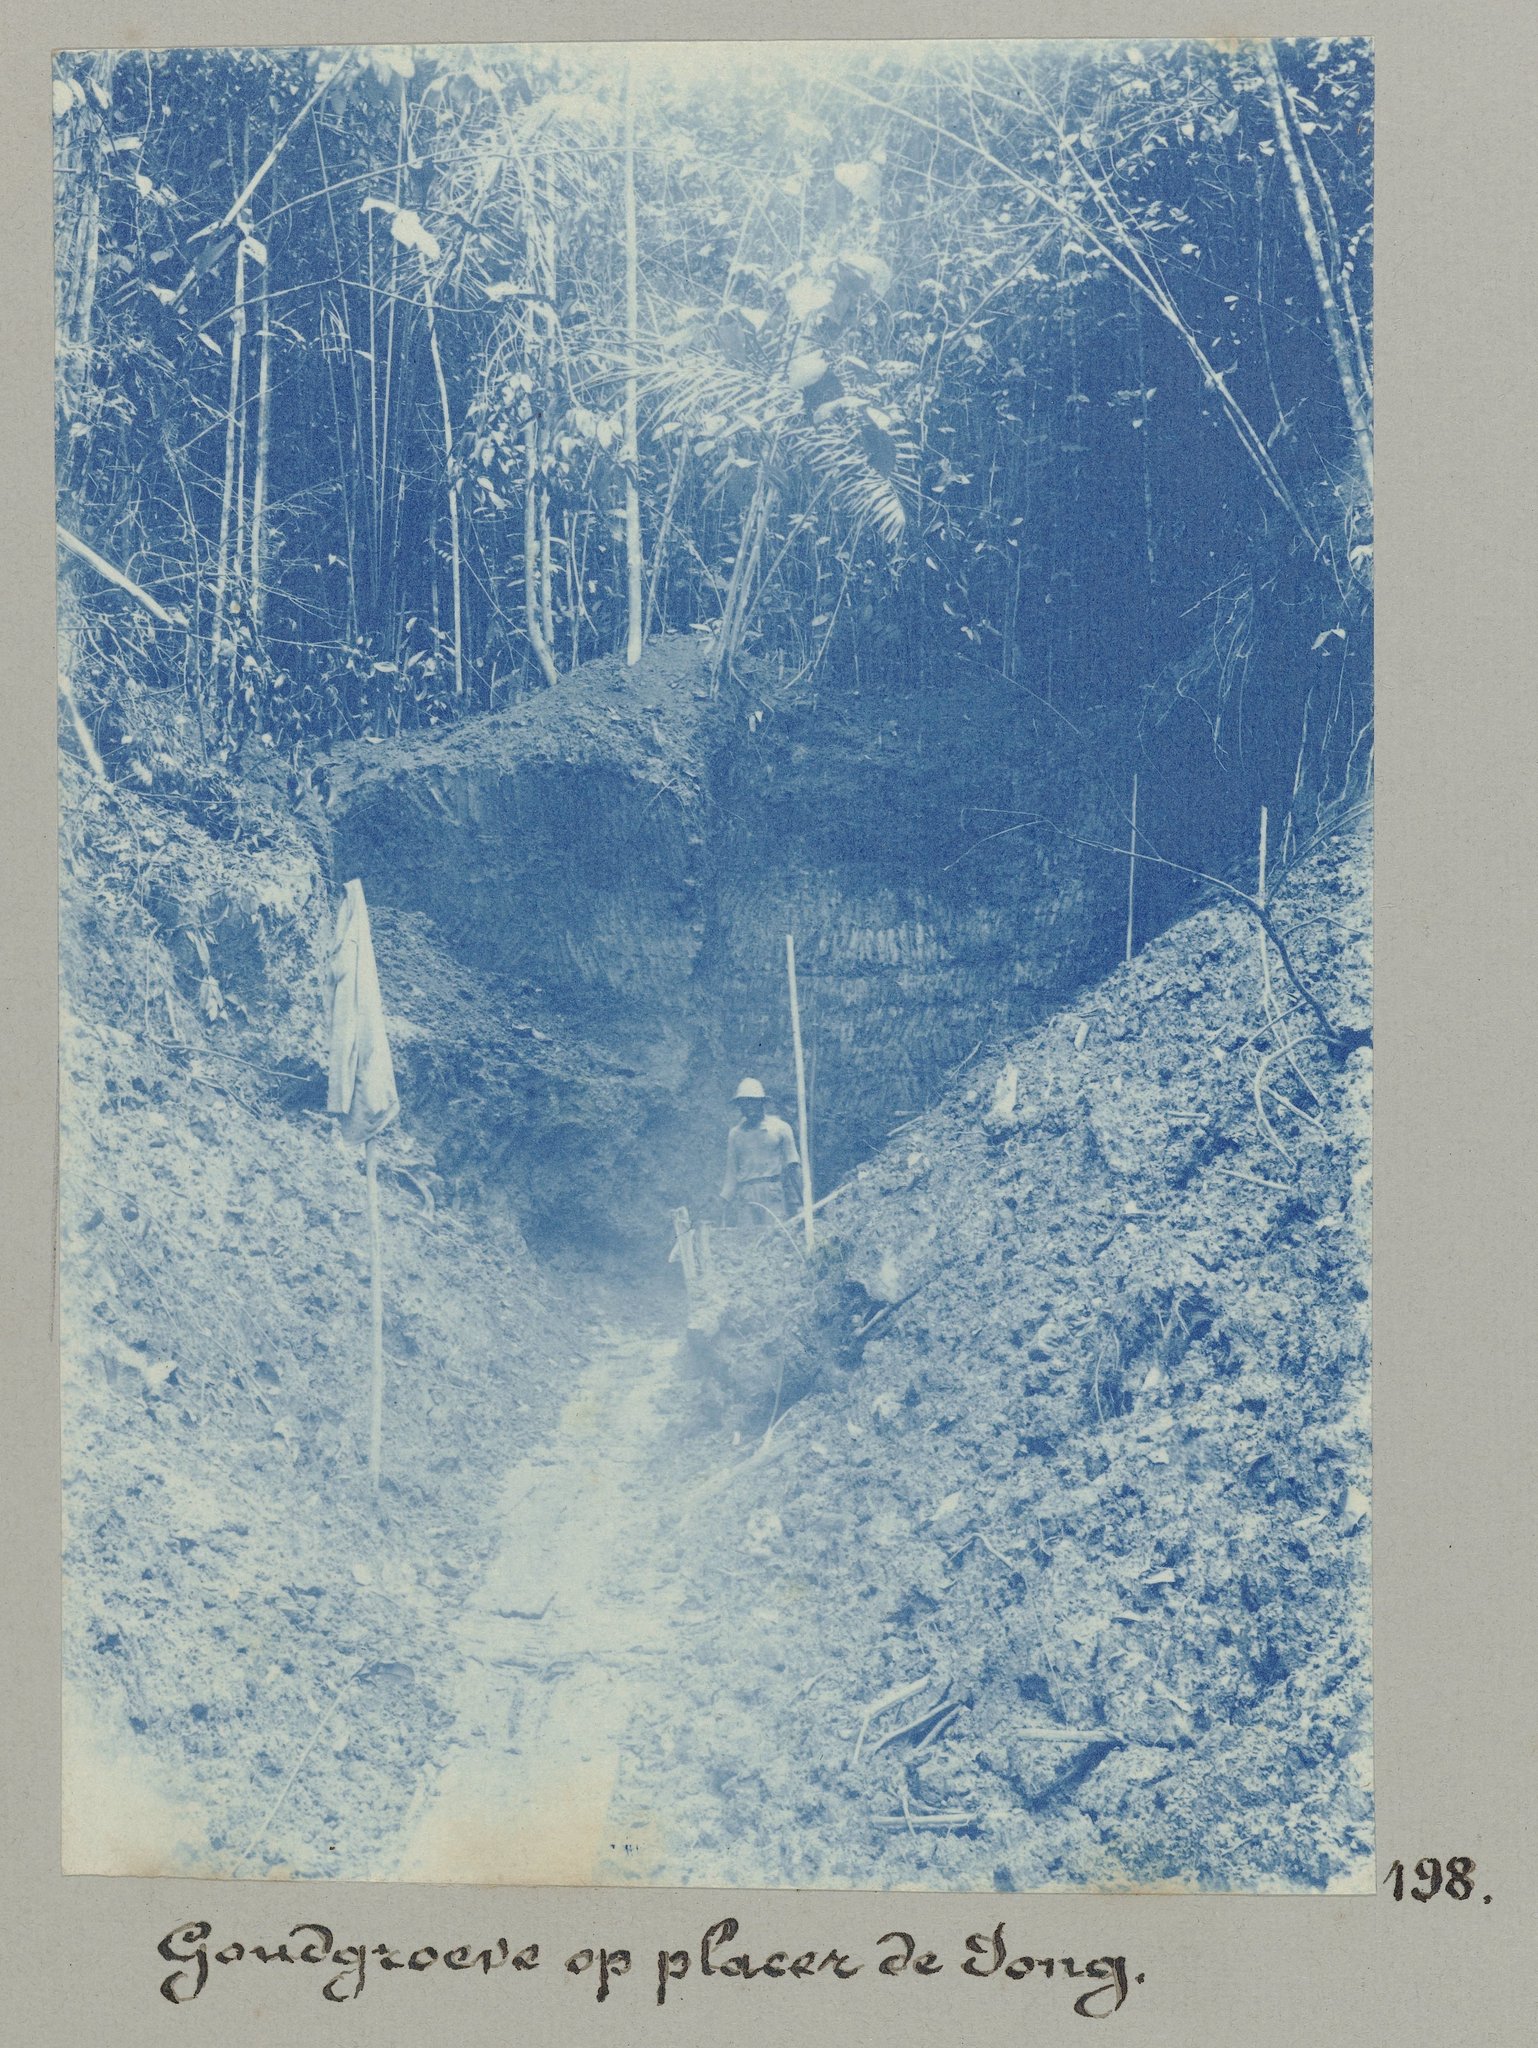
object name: photograph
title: Booten op Ma retraite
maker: hendrik doijer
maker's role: engineer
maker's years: 1863-1925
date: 1903-1910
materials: photographic support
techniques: cyanotype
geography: suriname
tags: suriname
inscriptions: inscription: ‘199. / Booten op Ma retraite.’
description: Bootjes in een sloot op de plantage Ma Retraite. Onderdeel van het fotoalbum Souvenir de Voyage (deel 5), over het leven van de familie Doijer in en rond de plantage Ma Retraite in Suriname in de jaren 1903-1910.